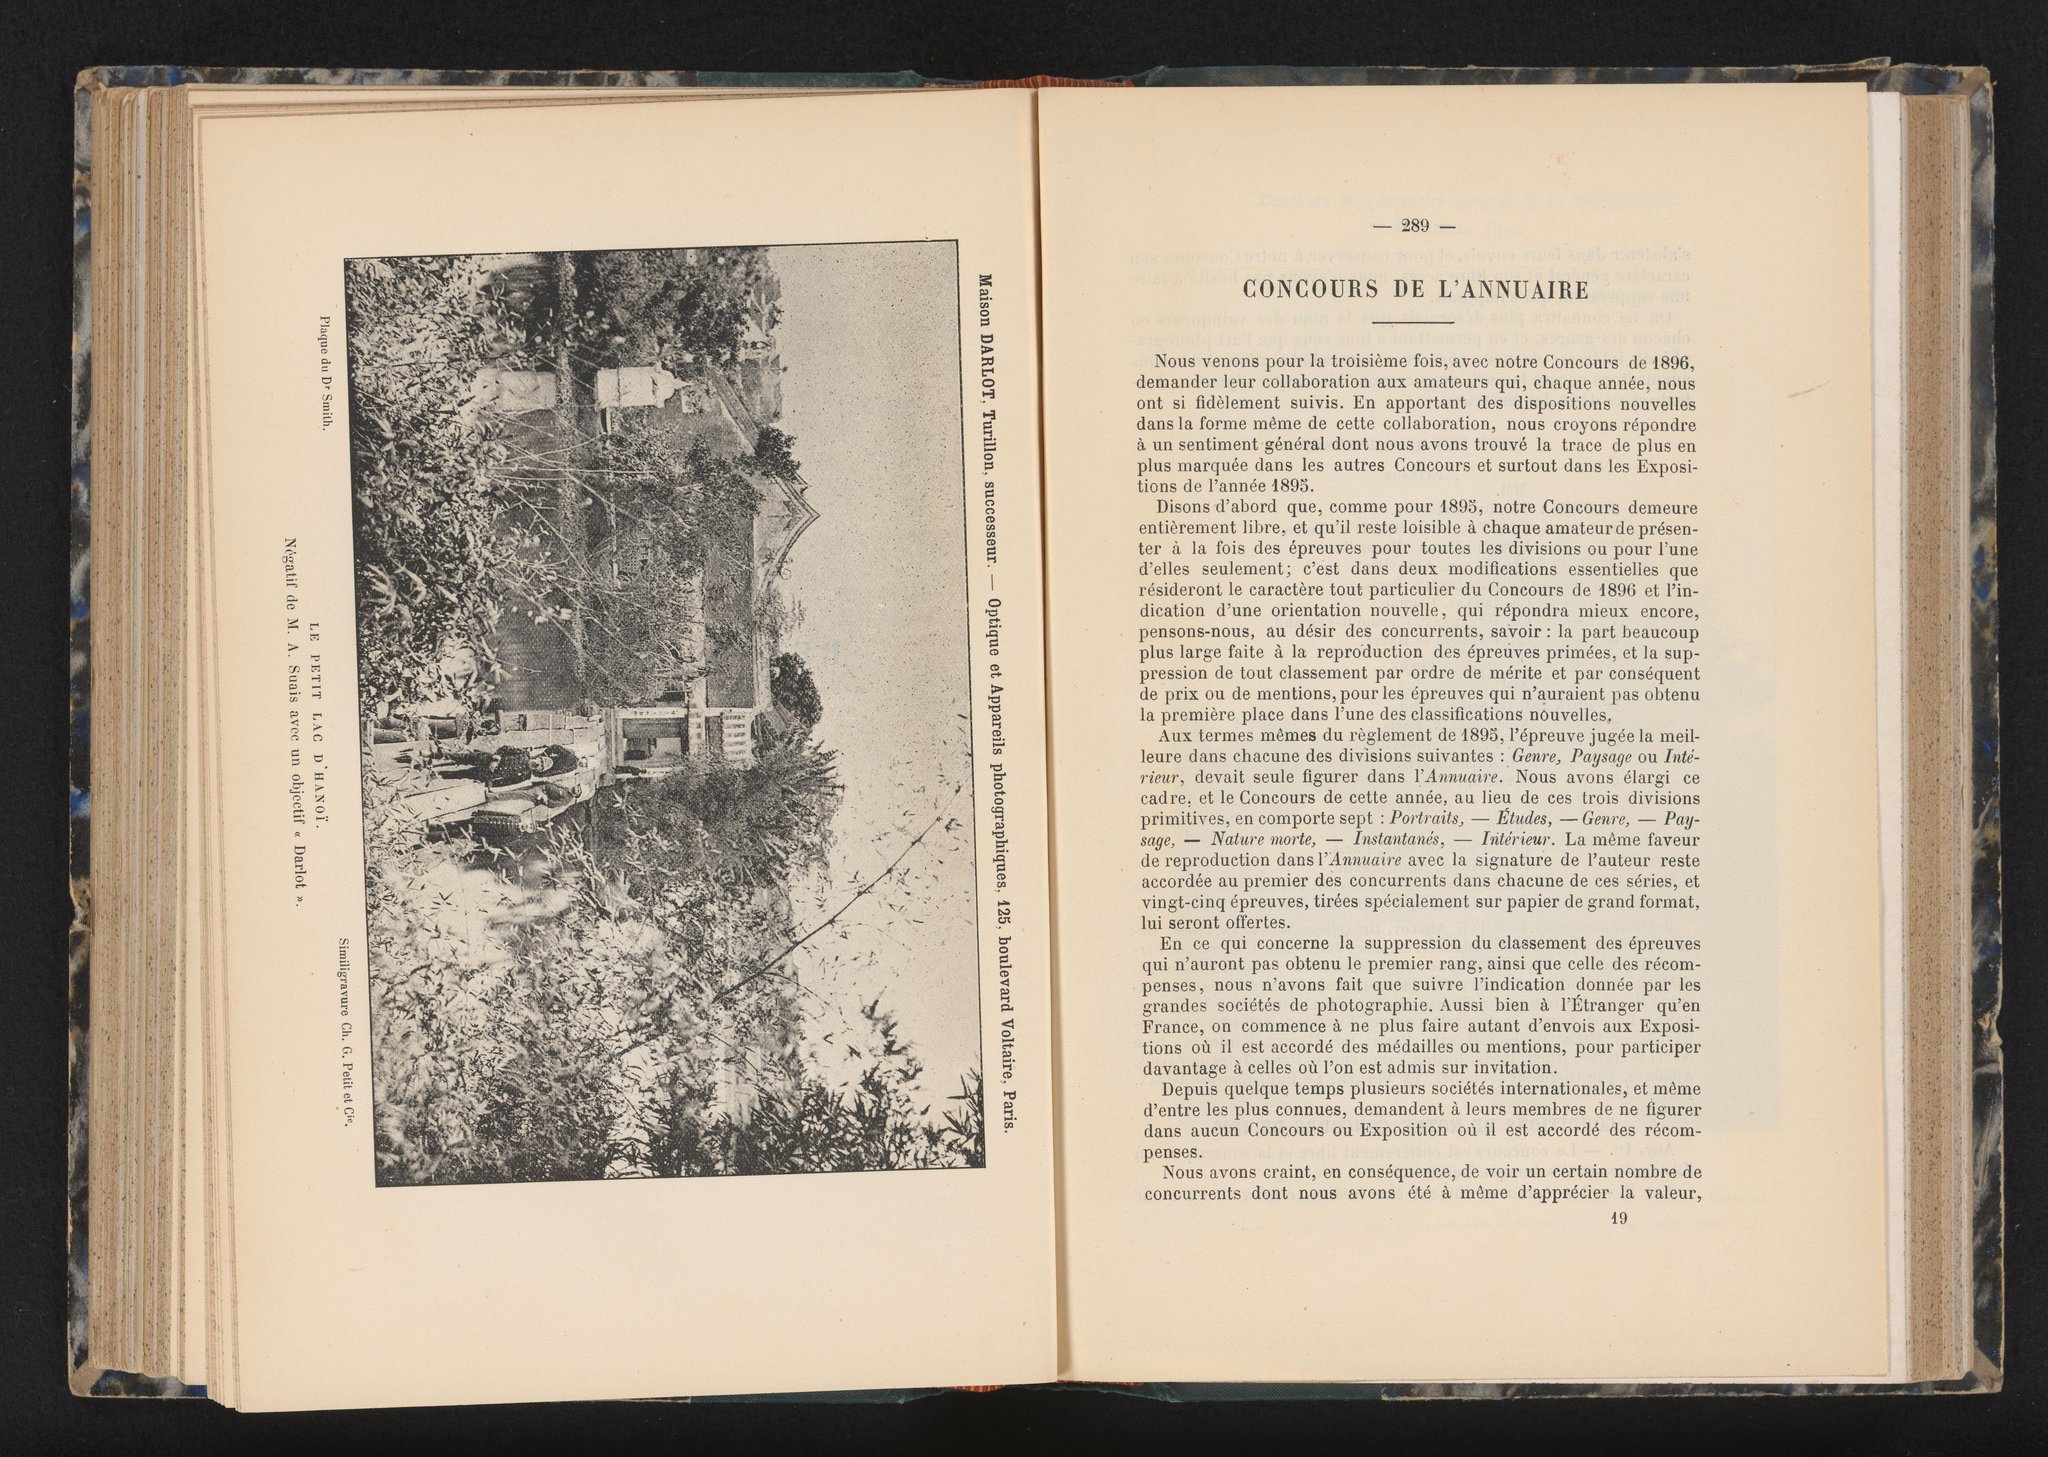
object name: photomechanical print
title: Vier militairen op een brug over Hoan Kiem Lake in Hanoi, Vietnam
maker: a. suais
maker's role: fotograaf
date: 1891-1896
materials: paper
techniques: autotype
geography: hanoi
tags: lake, warfare; military affairs, bridge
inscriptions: inscription: ‘Plaque du Dr Smith. Similigravure Ch. G Petit et Cie./ Négatif de M. A. Suais avec un objectif << Darlot >>.’, address: ‘Maison DARLOT, Turillon, successeur. - Optique et Appareils photographiques, 125, boulevard Voltaire, Paris.’